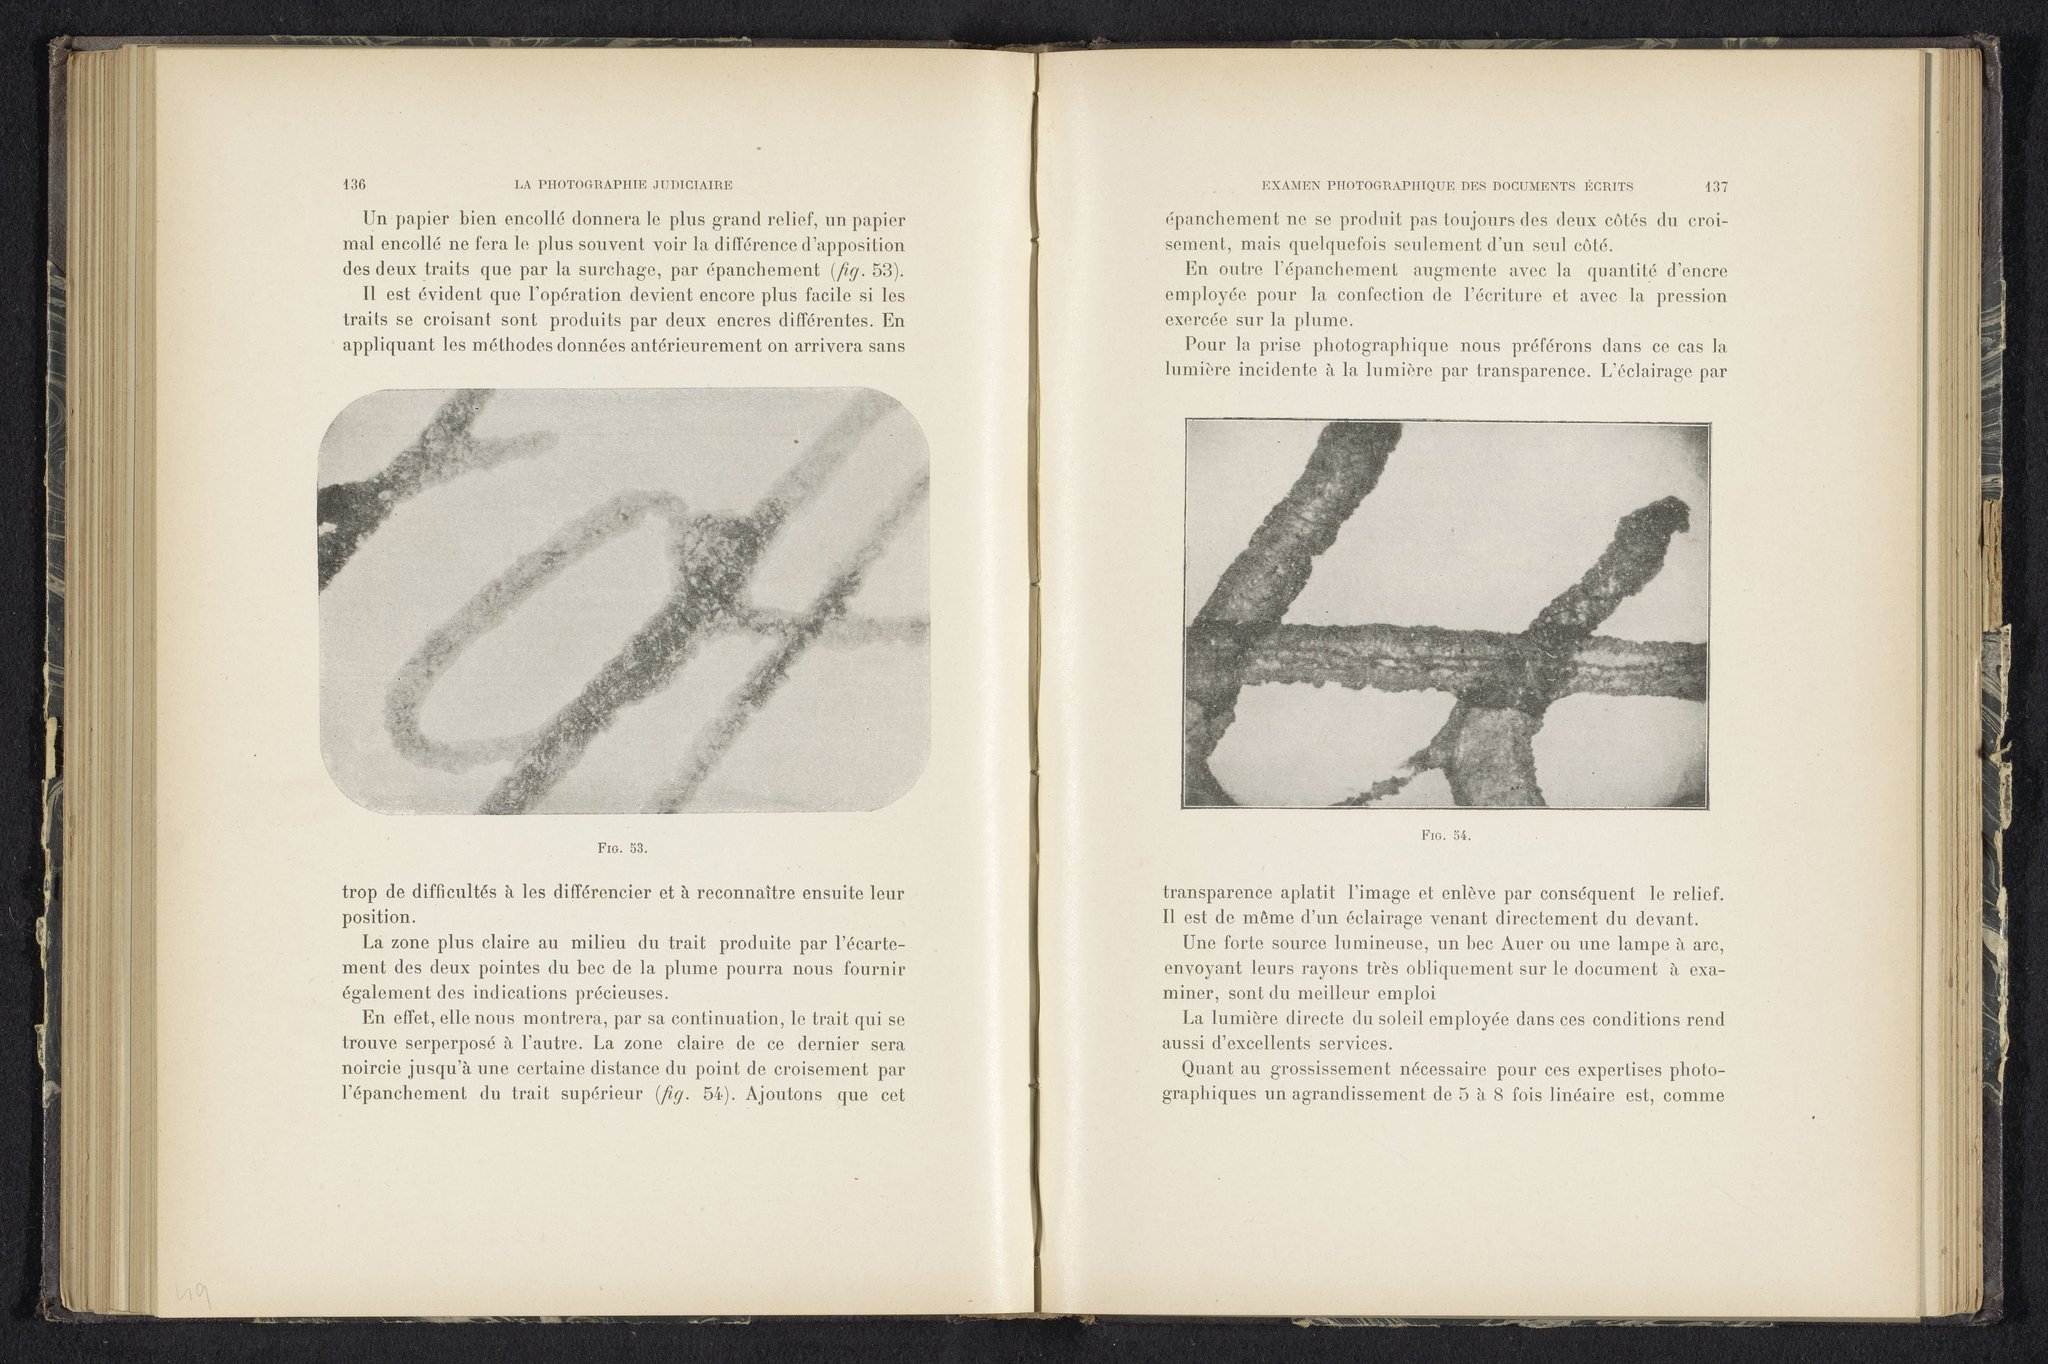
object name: page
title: Vergroting van geschreven tekst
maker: Anonymous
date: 1893-1903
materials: paper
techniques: autotype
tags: handwriting, written text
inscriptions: number: ‘Fig. 54.’